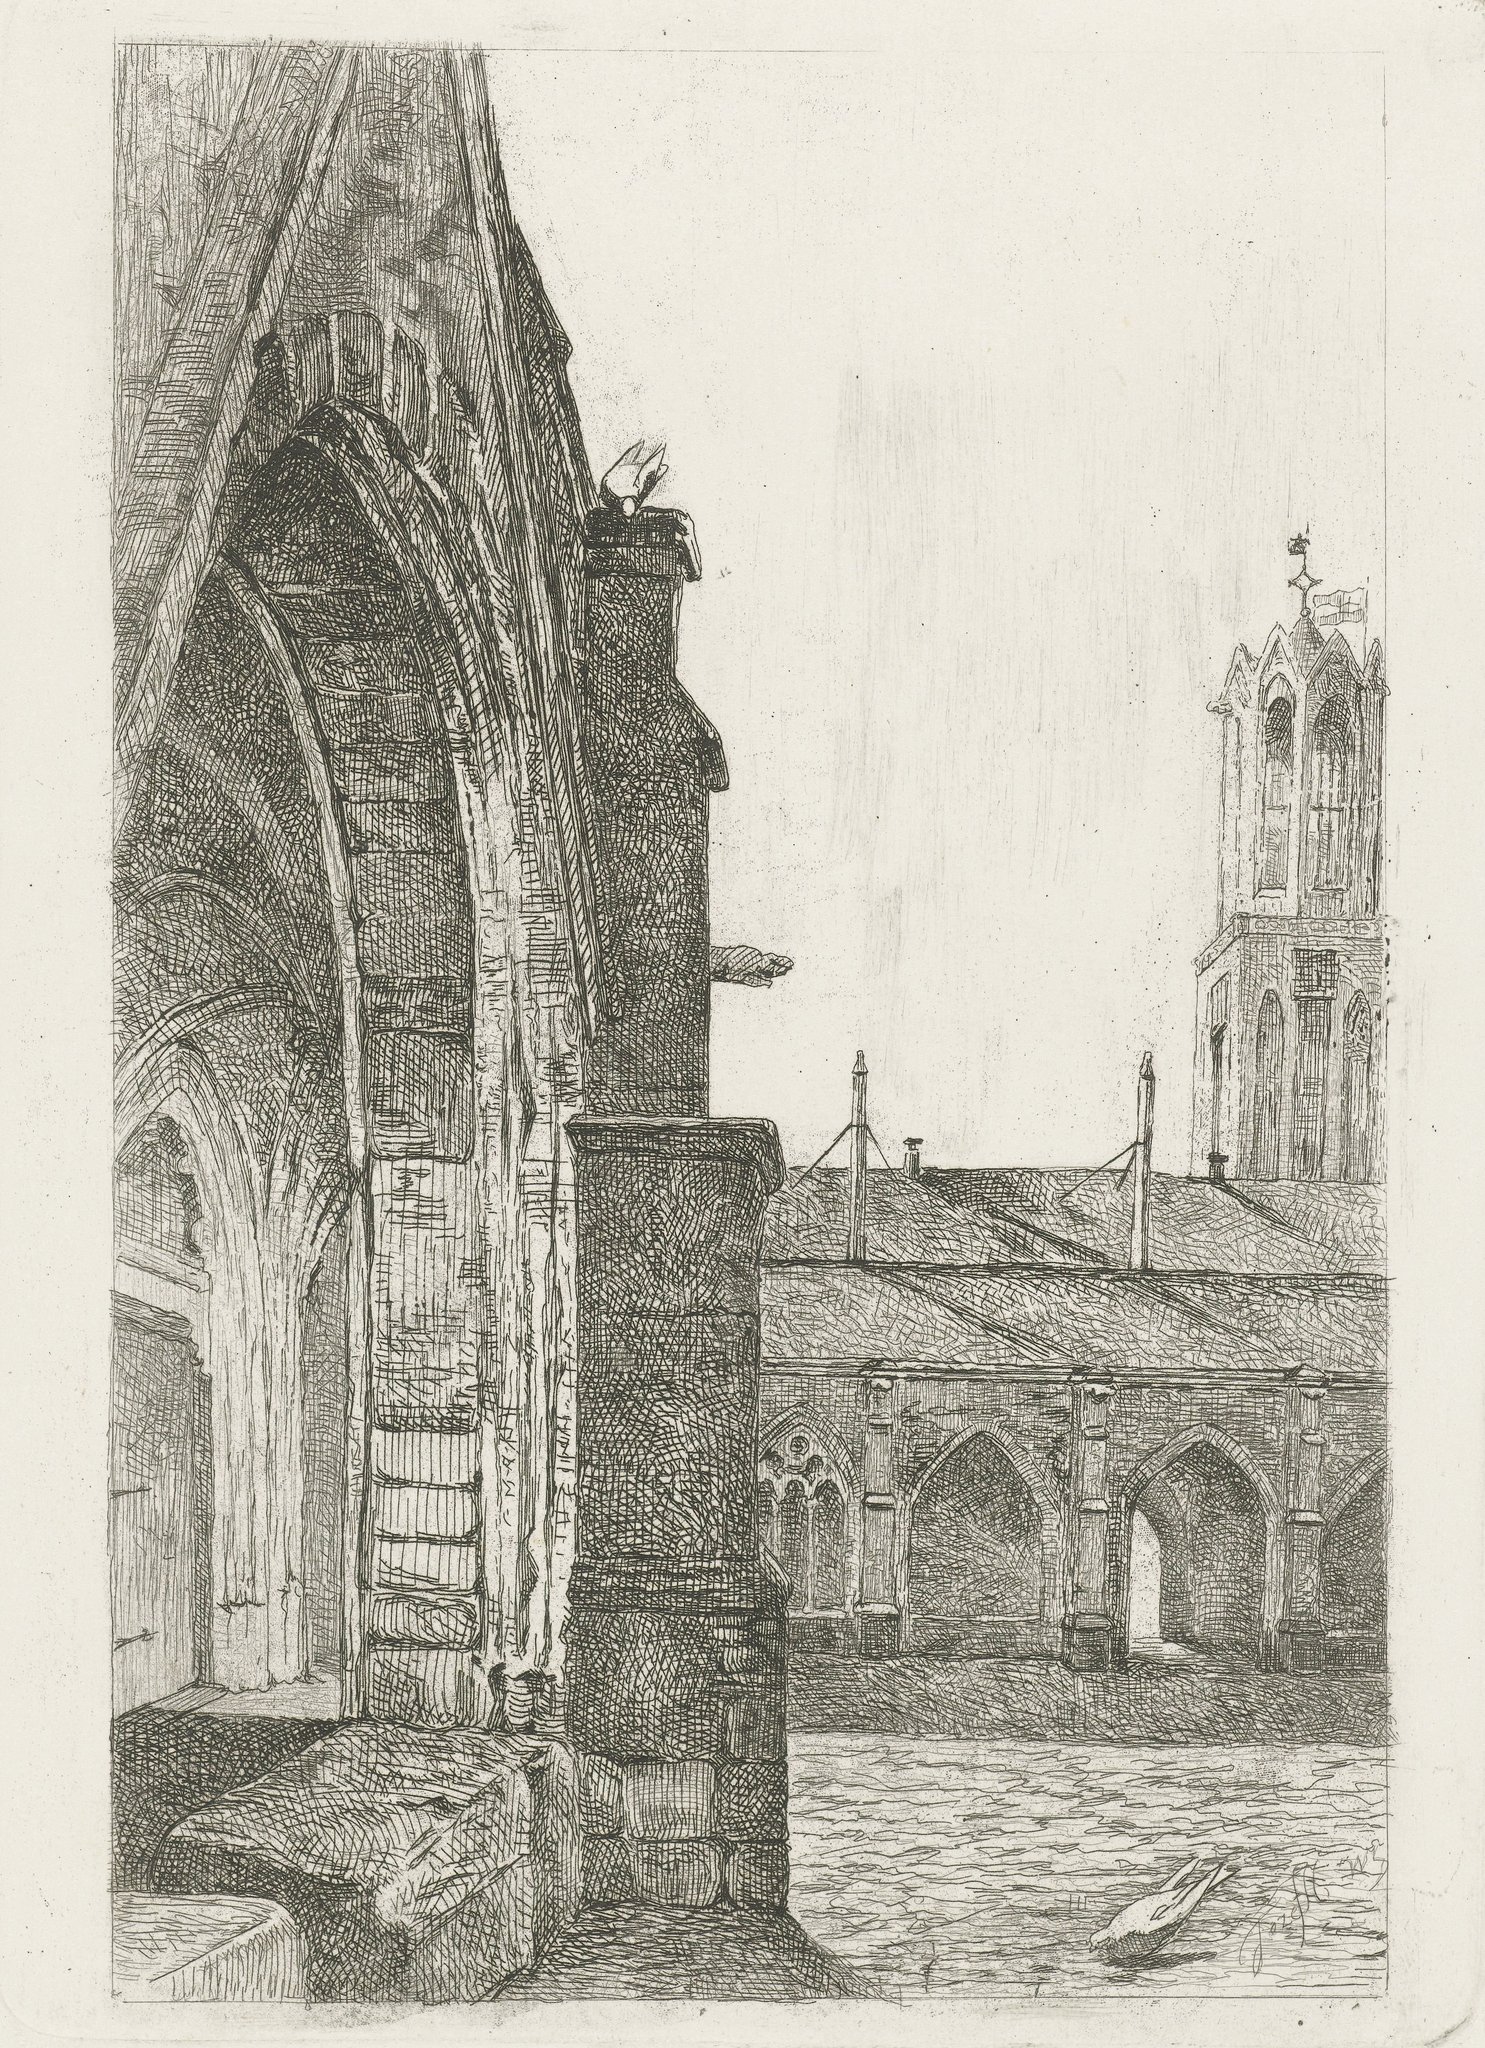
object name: print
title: Deel van een klooster bij de Dom van Utrecht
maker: jozef hoevenaar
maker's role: draughtsman, print maker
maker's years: 1840-1926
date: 1850-1883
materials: paper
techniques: etching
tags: church (exterior), cloisters ~ monastery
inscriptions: collector's mark: Lugt 2228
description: Gezicht op een kloostergang met links een deel van een ingang van een klooster bij de Dom van Utrecht.